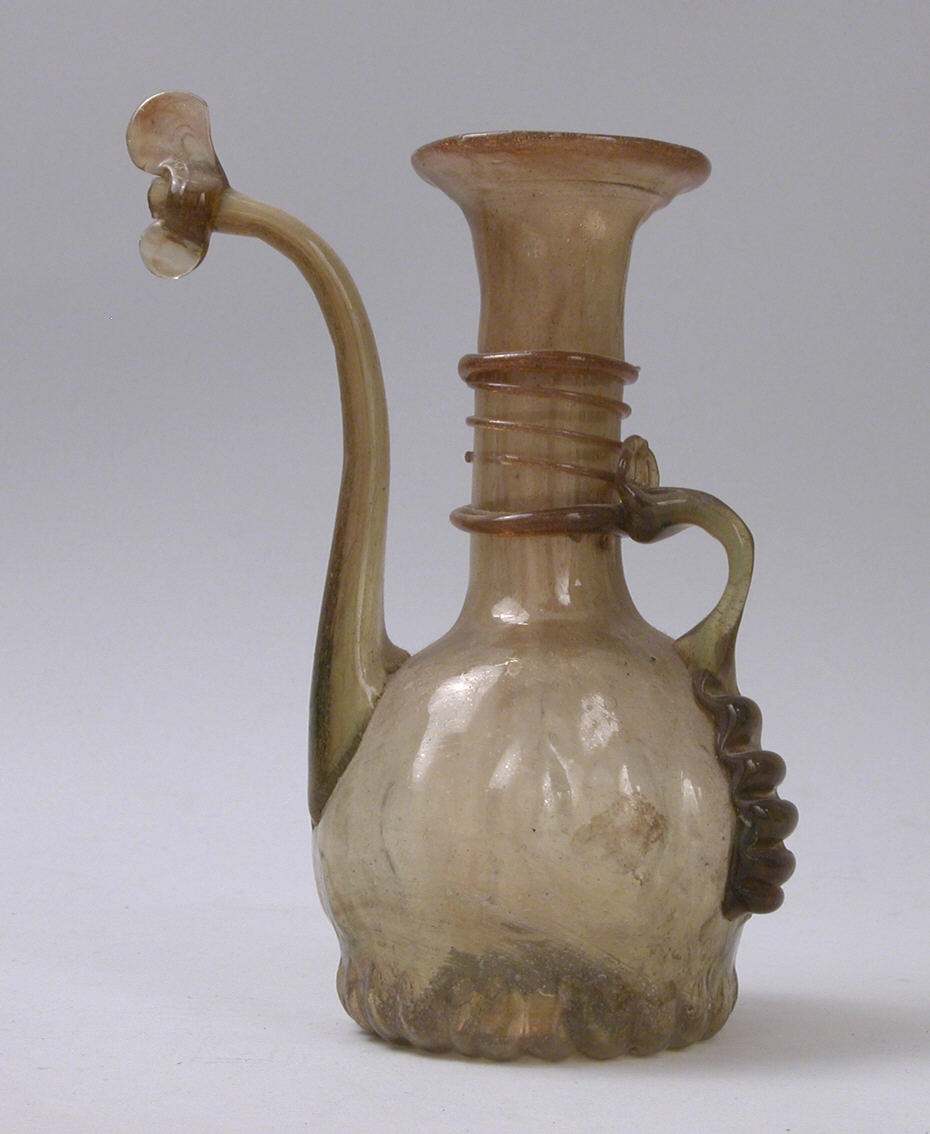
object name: ewer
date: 1701-1900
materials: glass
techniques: glassblowing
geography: iran